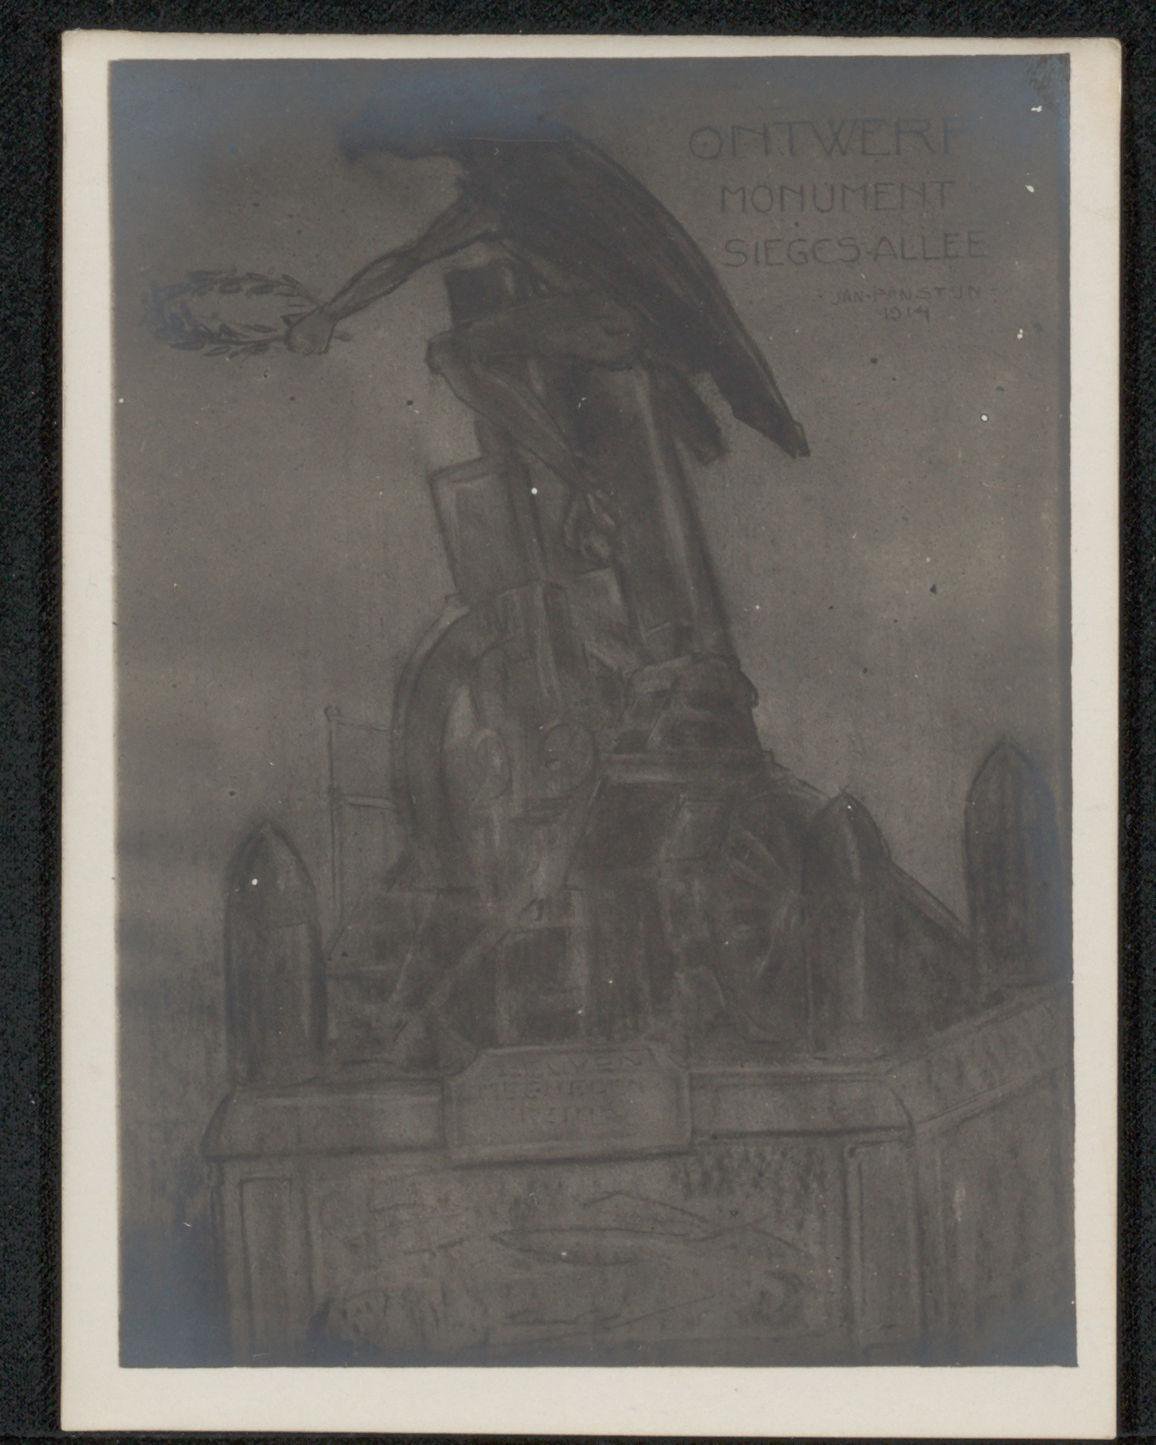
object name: photograph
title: Foto uit archief Philip Zilcken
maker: Anonymous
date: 1914-1930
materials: photographic support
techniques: gelatin silver print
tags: the hague, painter, draughtsman, philip zilcken, monument, statue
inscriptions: collector's mark: ‘RPK’